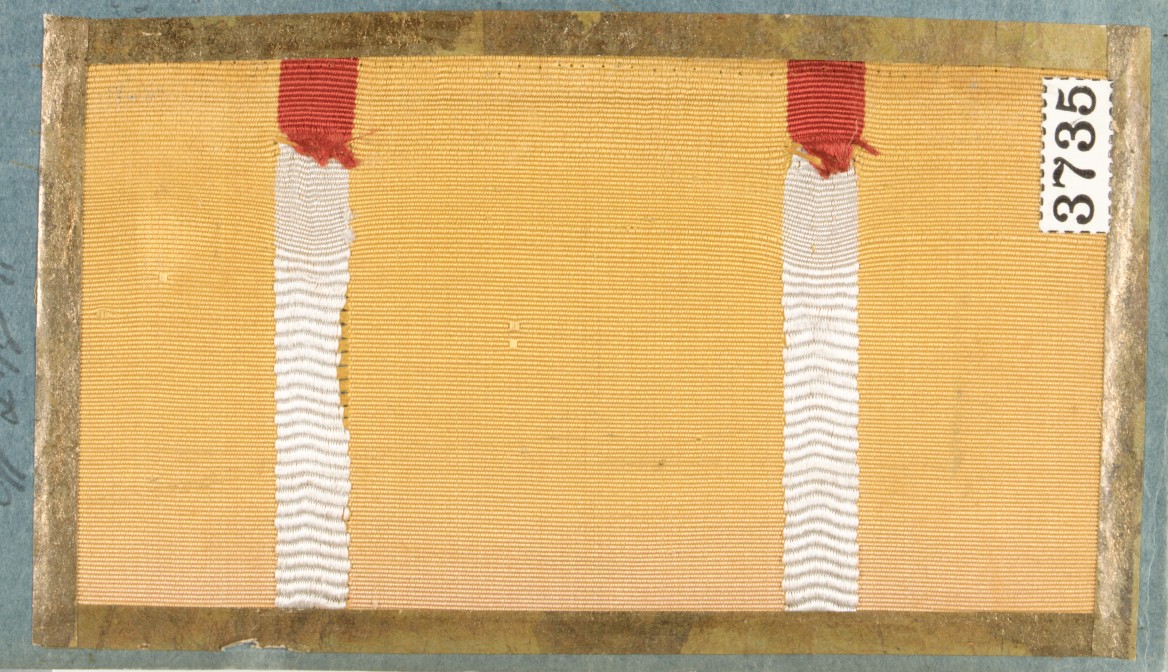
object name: sample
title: Textile Sample from Sample Book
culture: japanese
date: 1801-1900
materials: silk